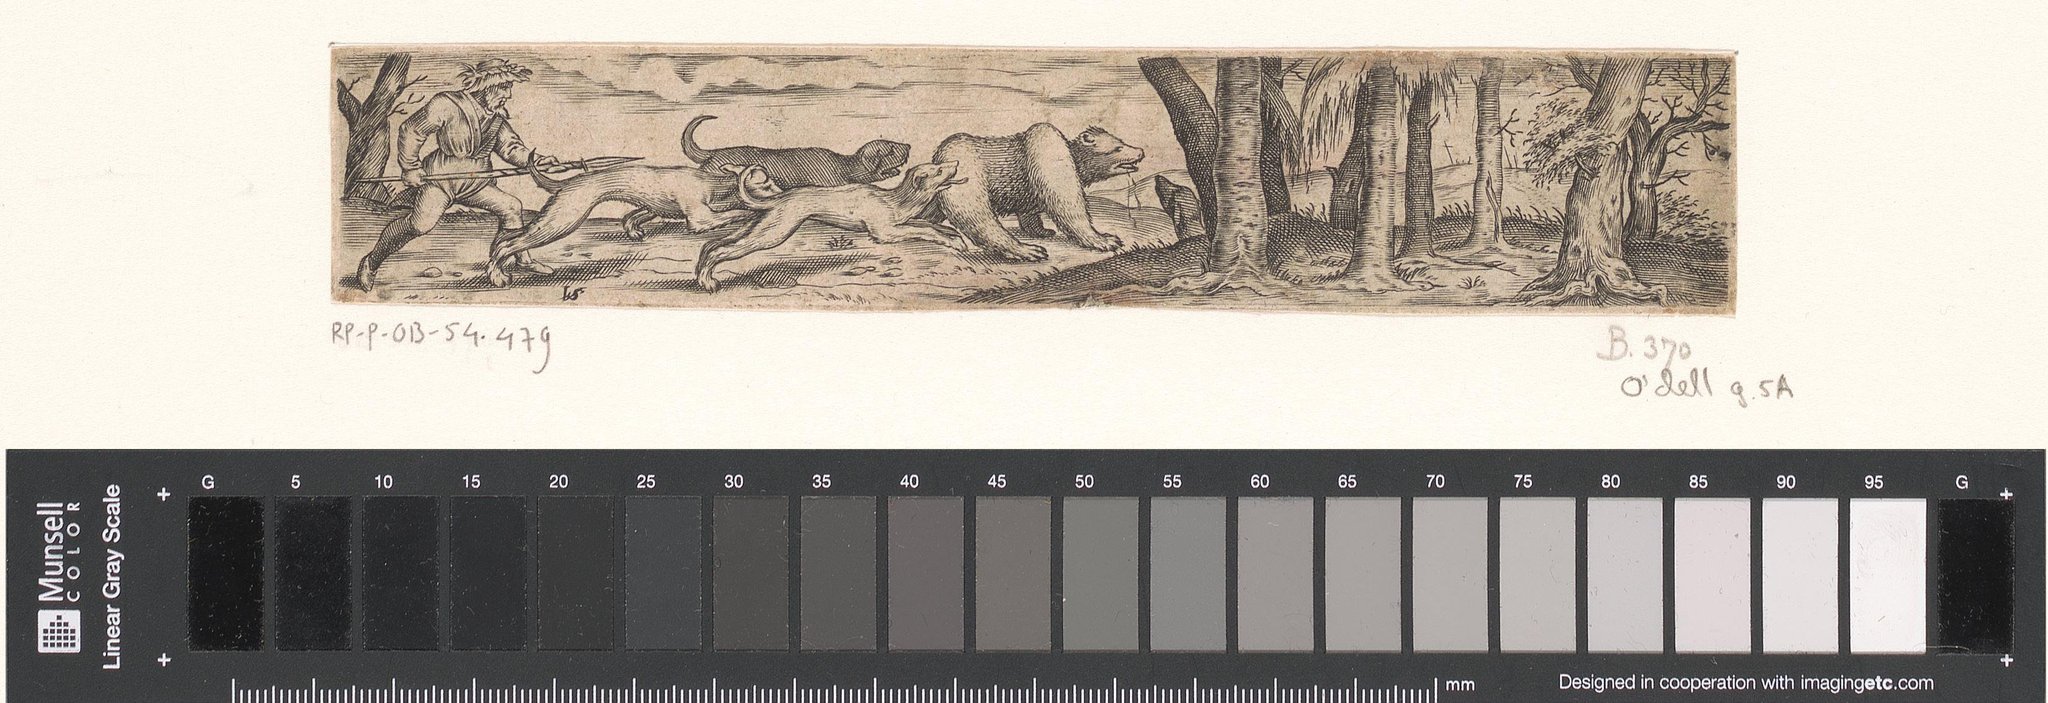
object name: print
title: Berenjacht met een jager en drie honden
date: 1541-1612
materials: paper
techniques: engraving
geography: nuremberg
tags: hunting dogs, beasts of prey, predatory animals: bear, hunt ~ mammals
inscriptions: number: ‘34’, collector's mark: Lugt 2228